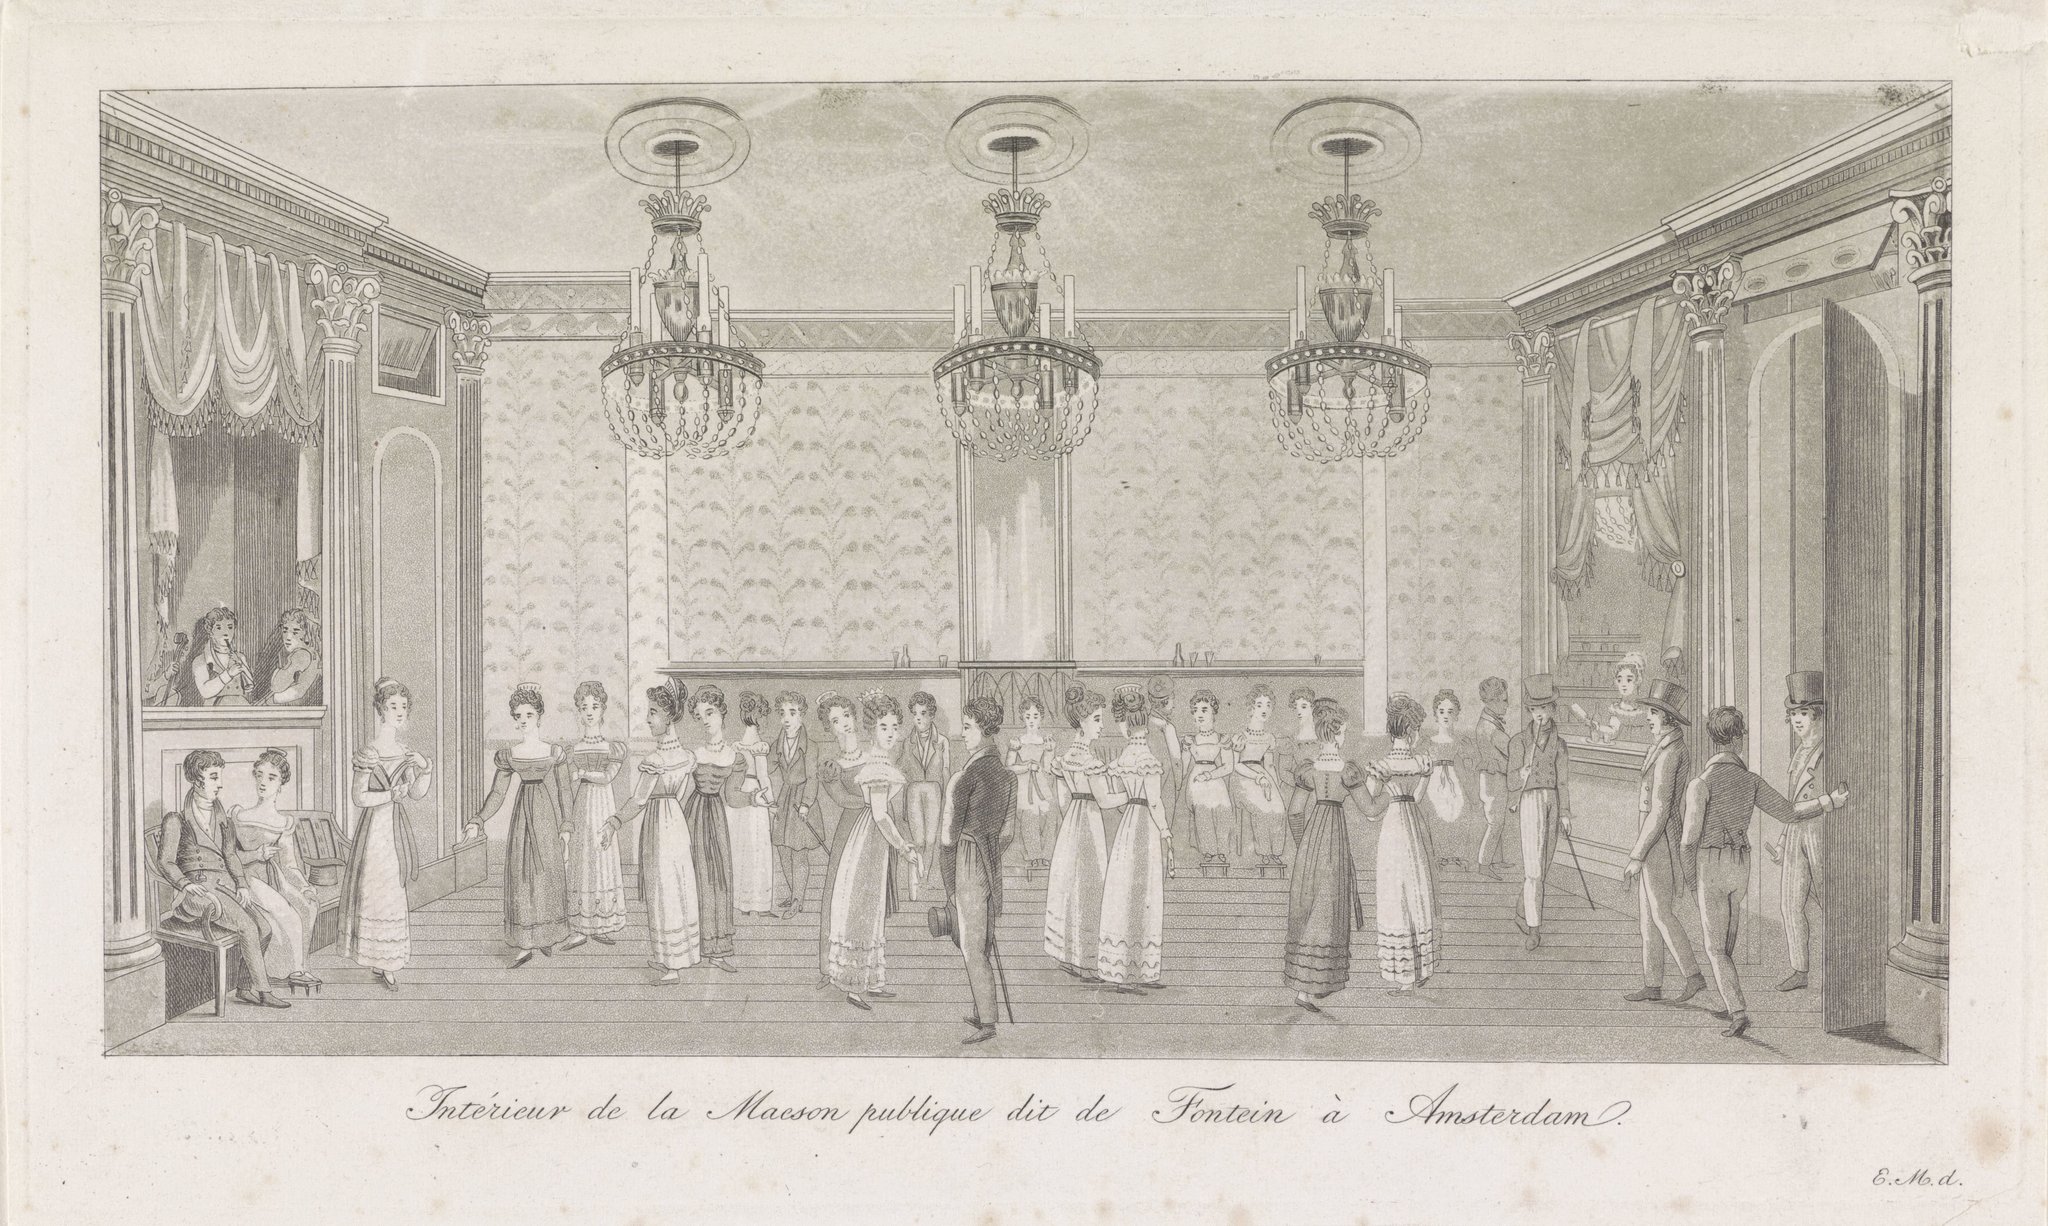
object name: print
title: Intérieur de la Maeson publique dit de Fontein à Amsterdam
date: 1820-1825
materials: paper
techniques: aquatint, etching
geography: netherlands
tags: brothel, night-club, dance-hall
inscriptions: collector's mark: Lugt 2228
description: Salon of danszaal in het speelhuis of club (of bordeel) genaamd 'De Fontein' op de Nieuwmarkt te Amsterdam, ca. 1820. Zaal waarin zich een aantal jongedames zich bevindt, rechts een bar en de deur waar enkele jongemannen de zaal binnenkomen.